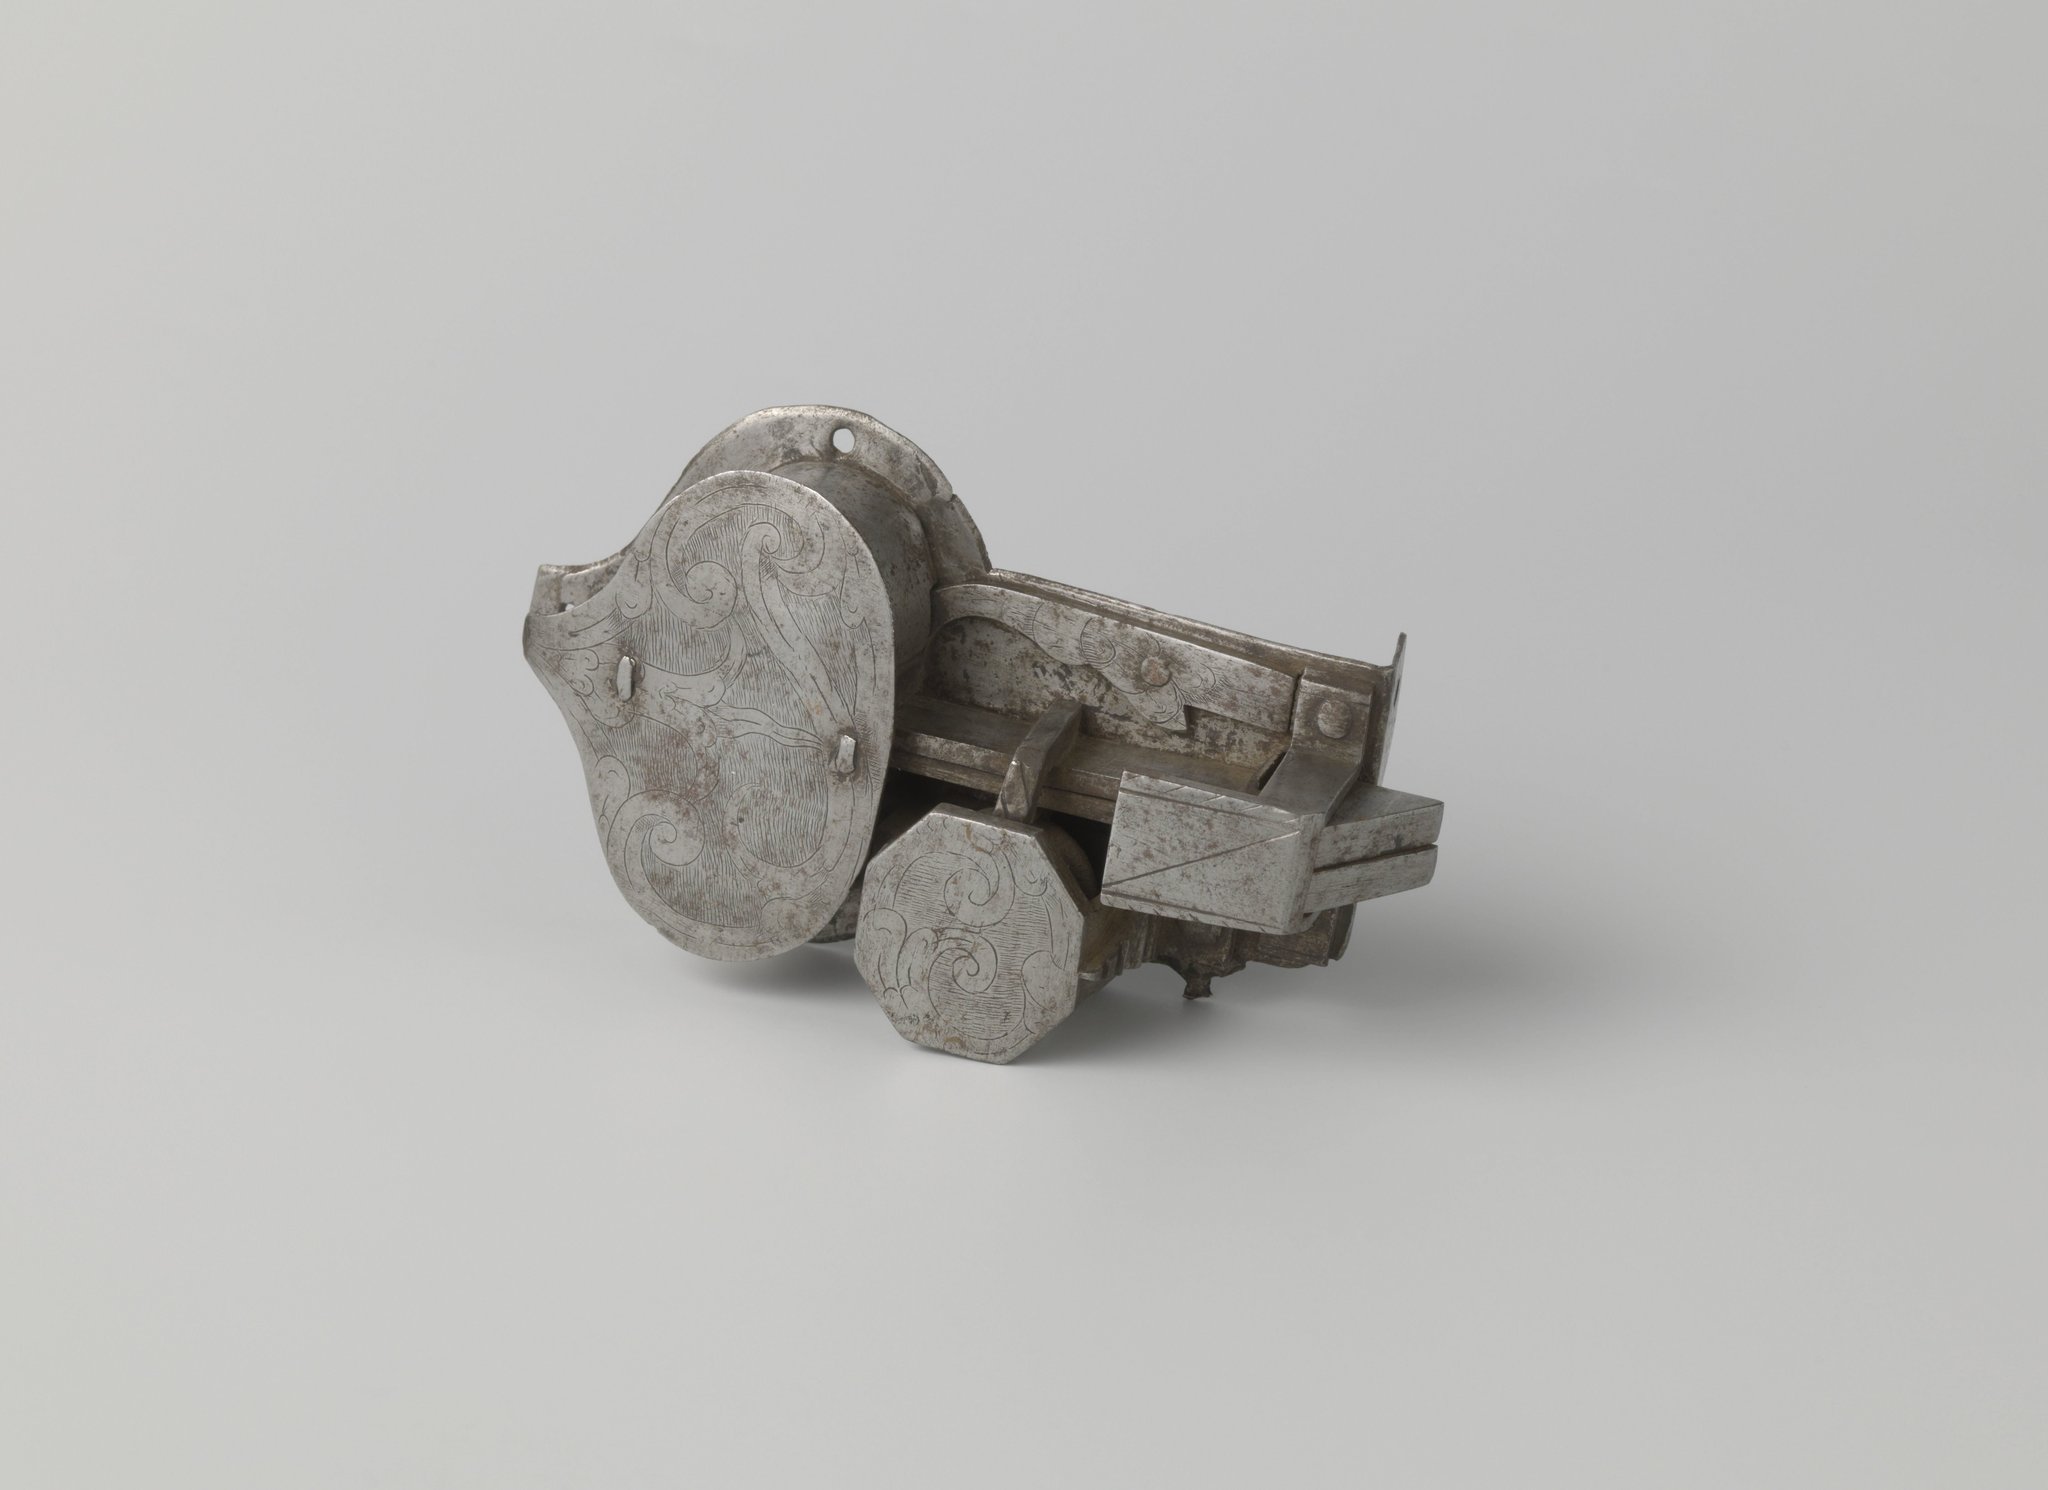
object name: lock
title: Slot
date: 1600-1699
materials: iron